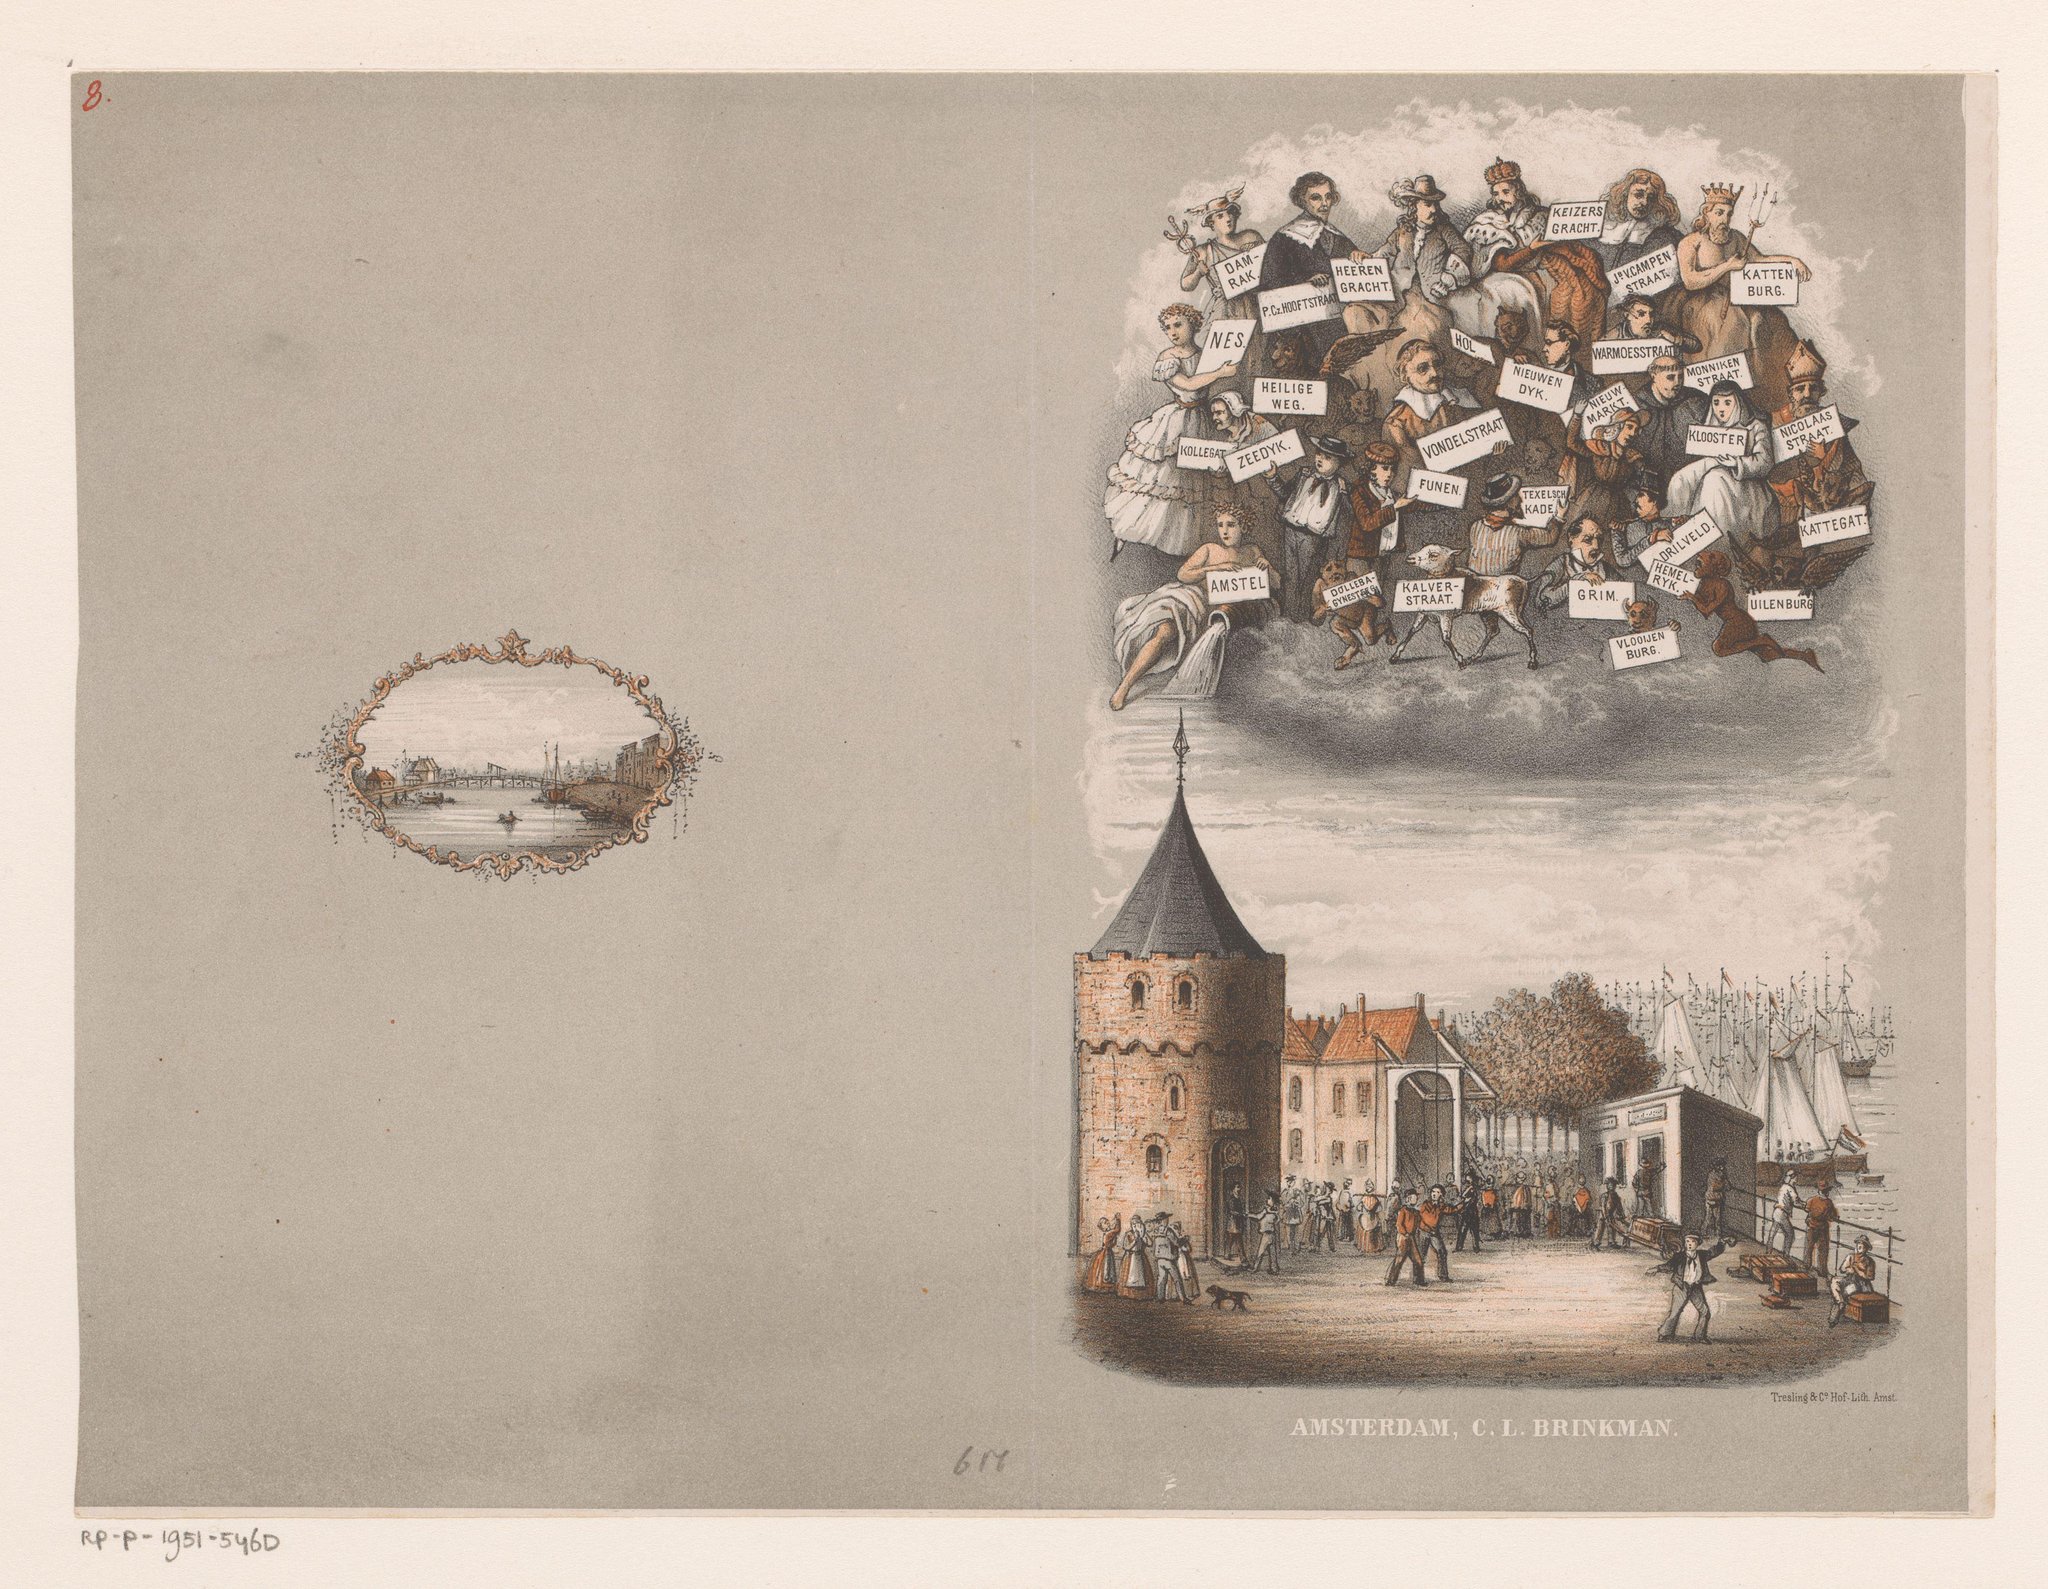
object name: wrapper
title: Omslag voor: Amsterdam. Oorsprong en afleiding van de namen der grachten, eilanden, pleinen, straten, stegen, bruggen, sluizen en torens dezer stad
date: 1865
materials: paper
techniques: tone lithography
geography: amsterdam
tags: city-view in general; 'veduta', amsterdam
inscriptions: collector's mark: Lugt 2228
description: Onderin de Schreierstoren in Amsterdam. Op straat een menigte. Bovenin verschillende historische figuren en types met borden die verwijzen naar plaatsen in Amsterdam. Links een vignet met gezicht op een rivier met brug.